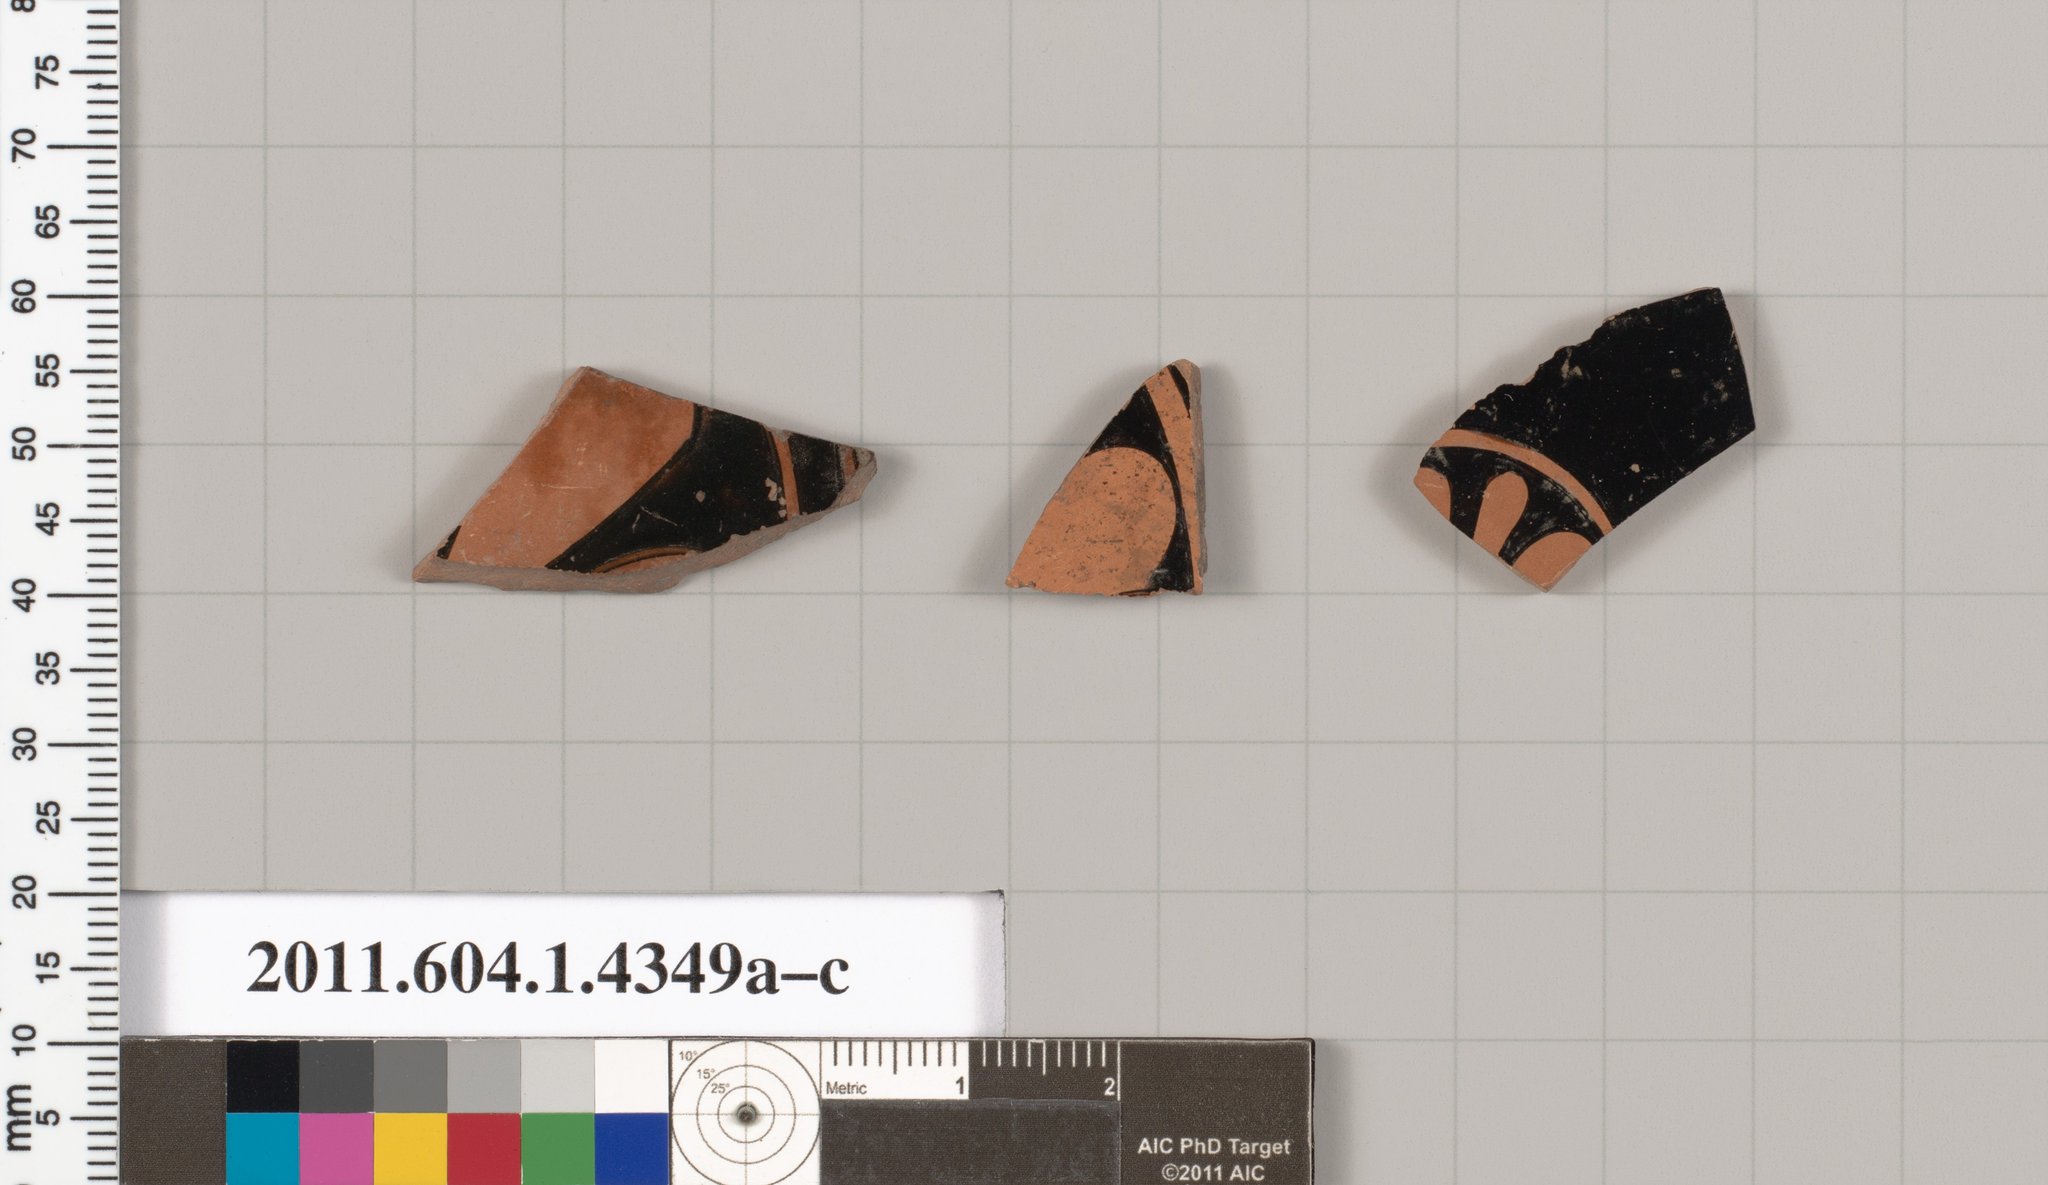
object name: kylix fragment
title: Terracotta fragments of kylikes (drinking cups)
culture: greek, attic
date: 520-500 BCE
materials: terracotta